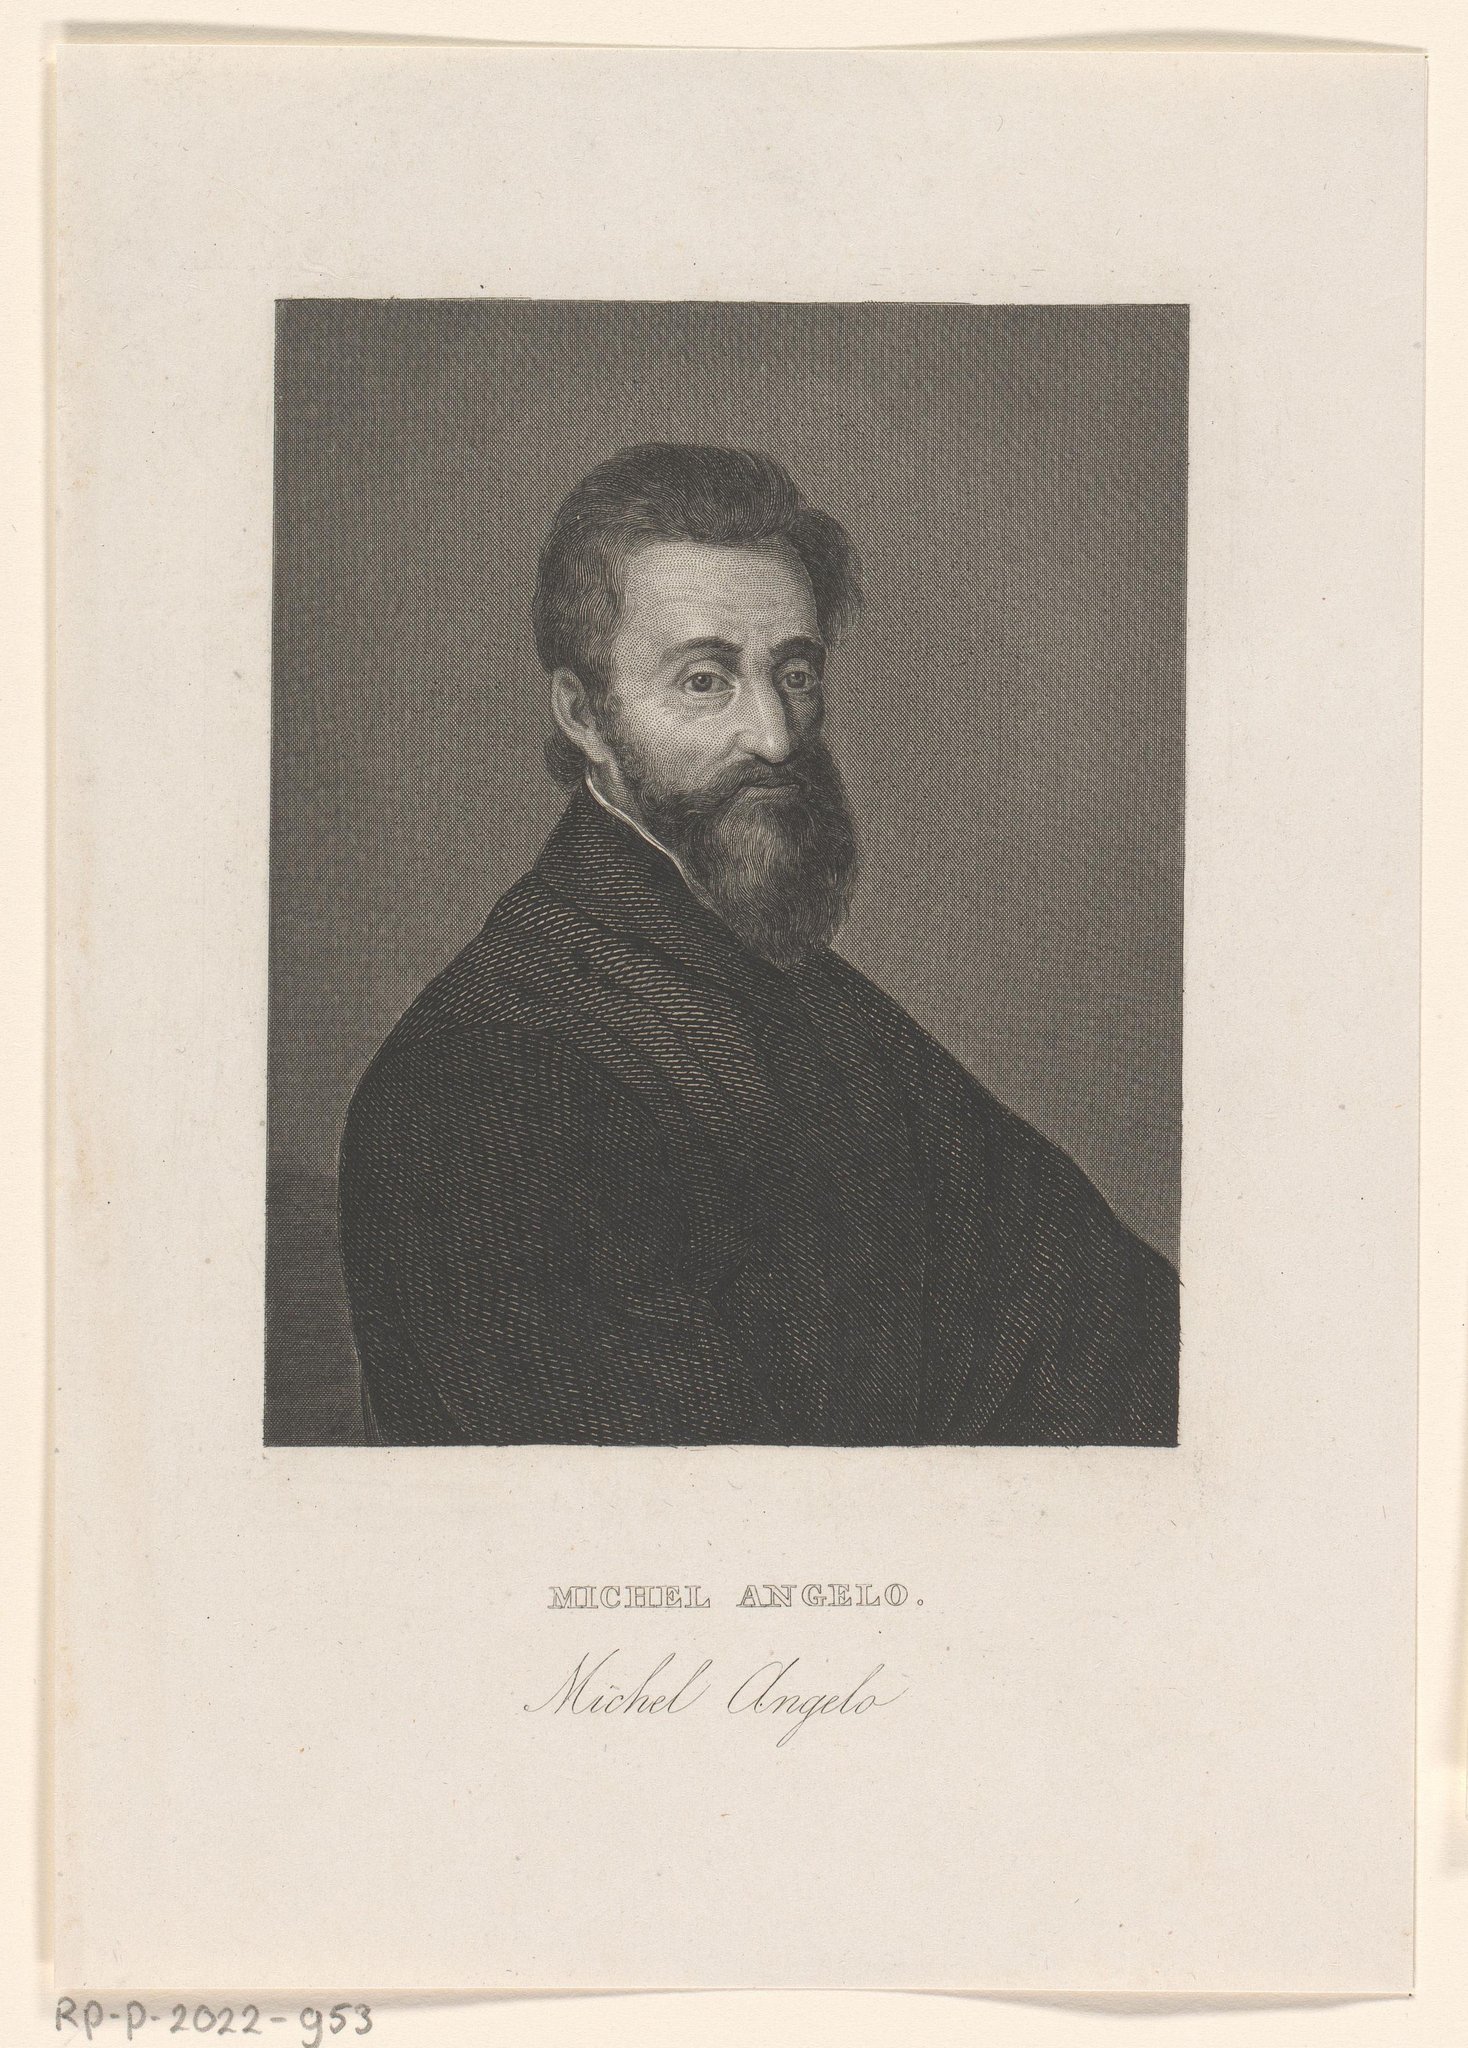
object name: print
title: Portret van Michelangelo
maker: Anonymous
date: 1859-1868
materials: paper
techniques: engraving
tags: rome, painter, draughtsman, sculptor, michelangelo, historical persons, portrait, self-portrait of artist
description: Prent waarschijnlijk uit een deel van: Encyklopedia Powszechna. S.l.s.n, 1859-1868, 28 dl.